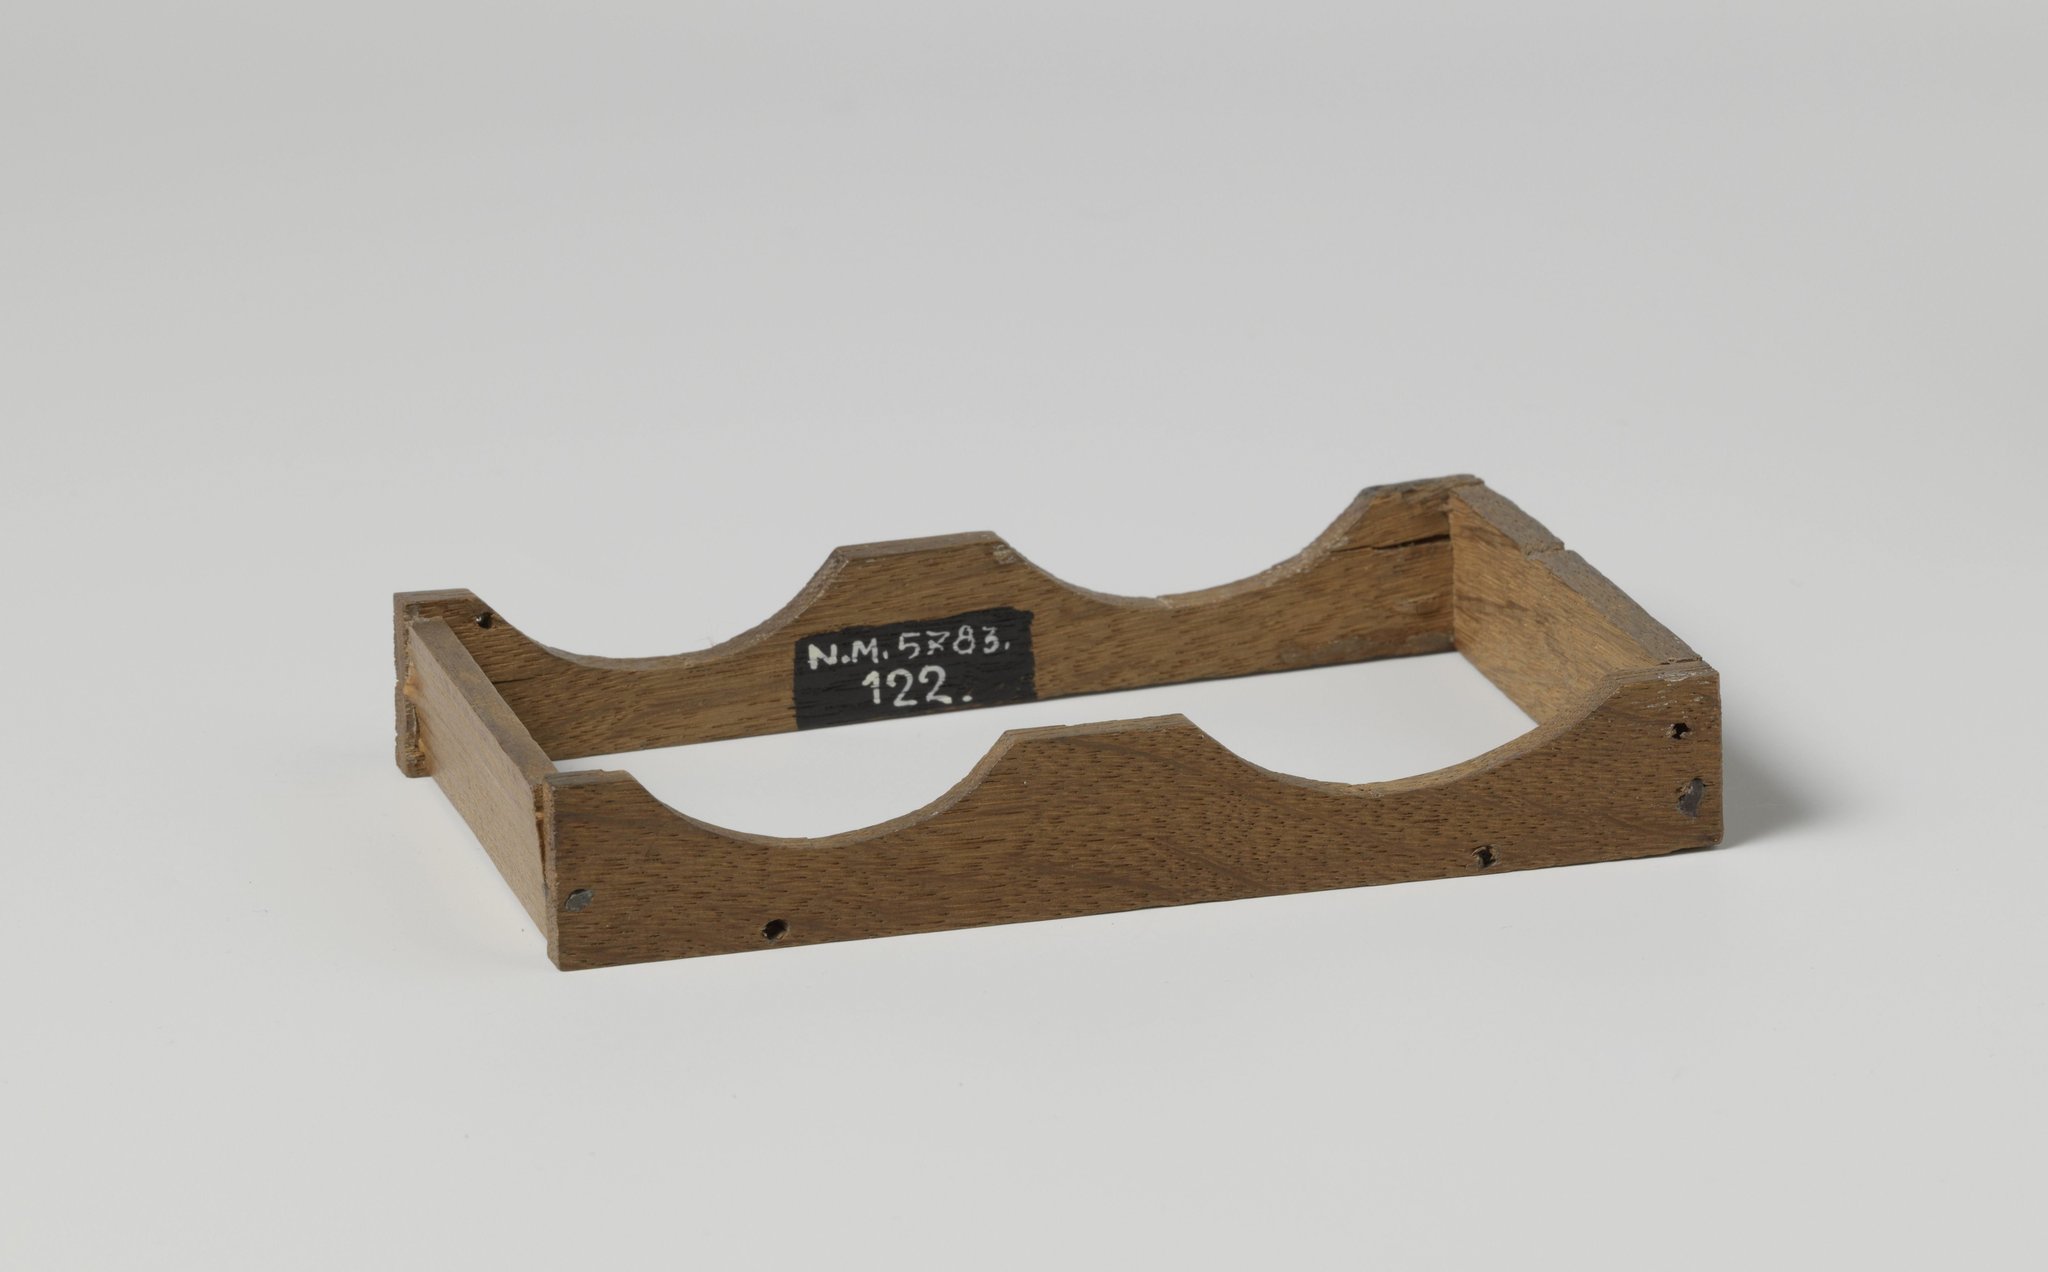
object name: bierstelling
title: Bierstelling voor twee vaten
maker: Anonymous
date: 1700-1799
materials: wood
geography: amsterdam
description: Een stelling van eikenhout, iets dieper uitlopend, met twee uithollingen voor de vaten.